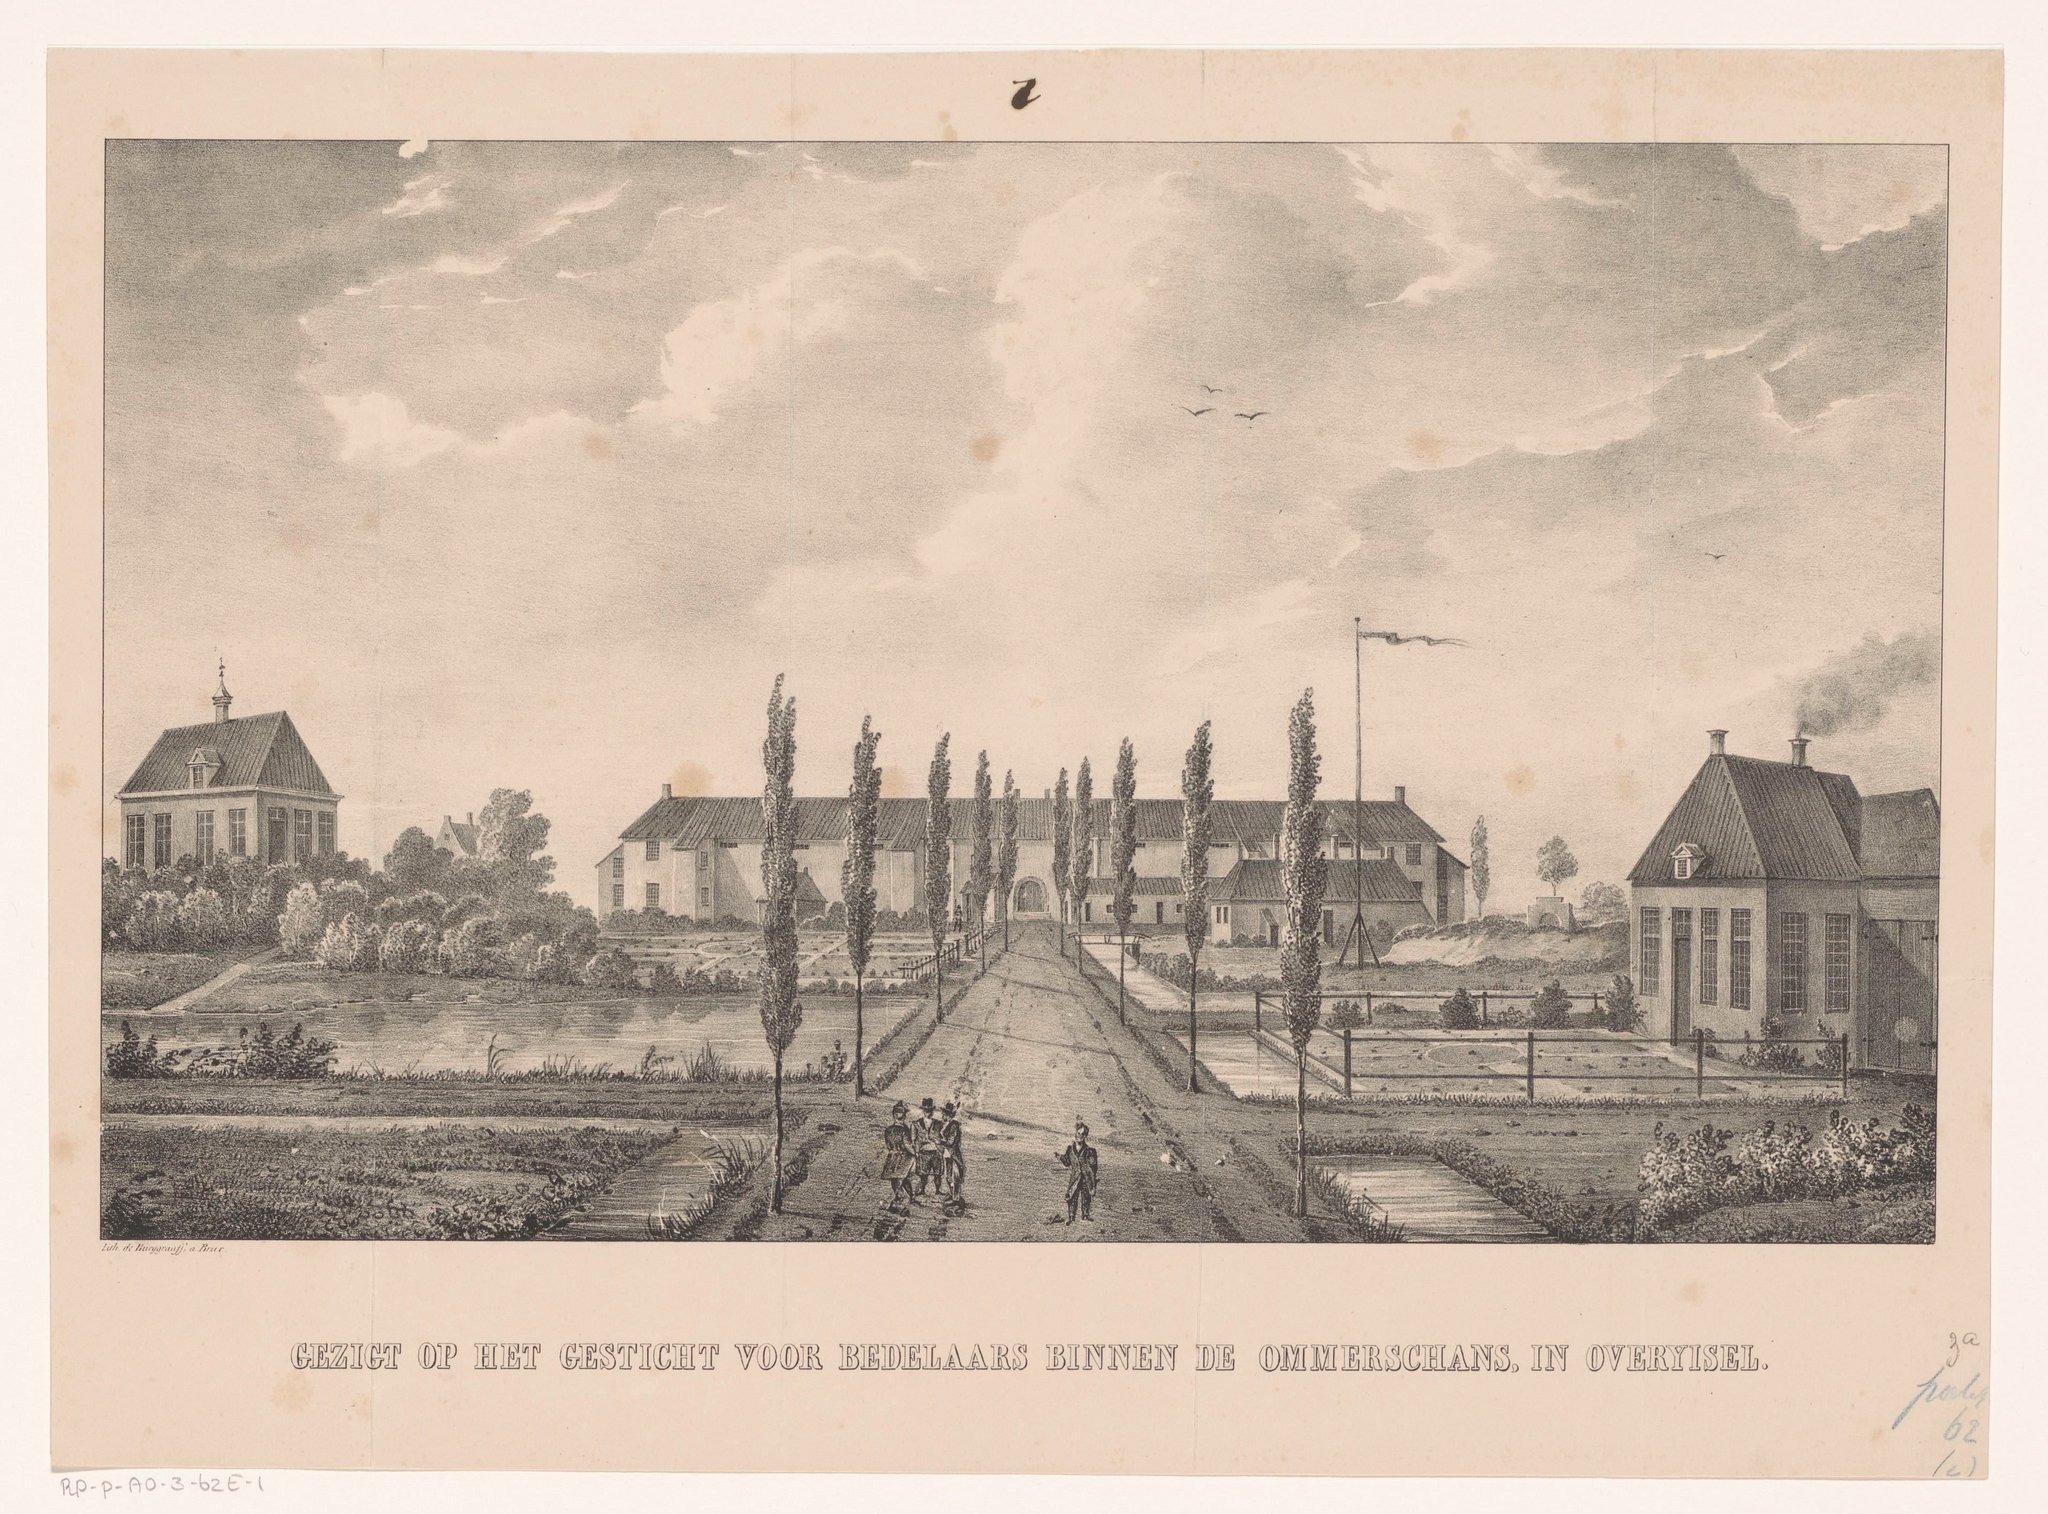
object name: print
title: Gesticht voor bedelaars binnen de Ommerschans (voorzijde), 1819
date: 1825-1835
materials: paper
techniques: lithograph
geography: belgium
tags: maatschappij van weldadigheid, ommerschans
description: Gezicht op het gesticht voor bedelaars binnen de Ommerschans (voorzijde), in Overijssel, opgericht door de Maatschappij van Weldadigheid in 1819. Zie ook de pendant.